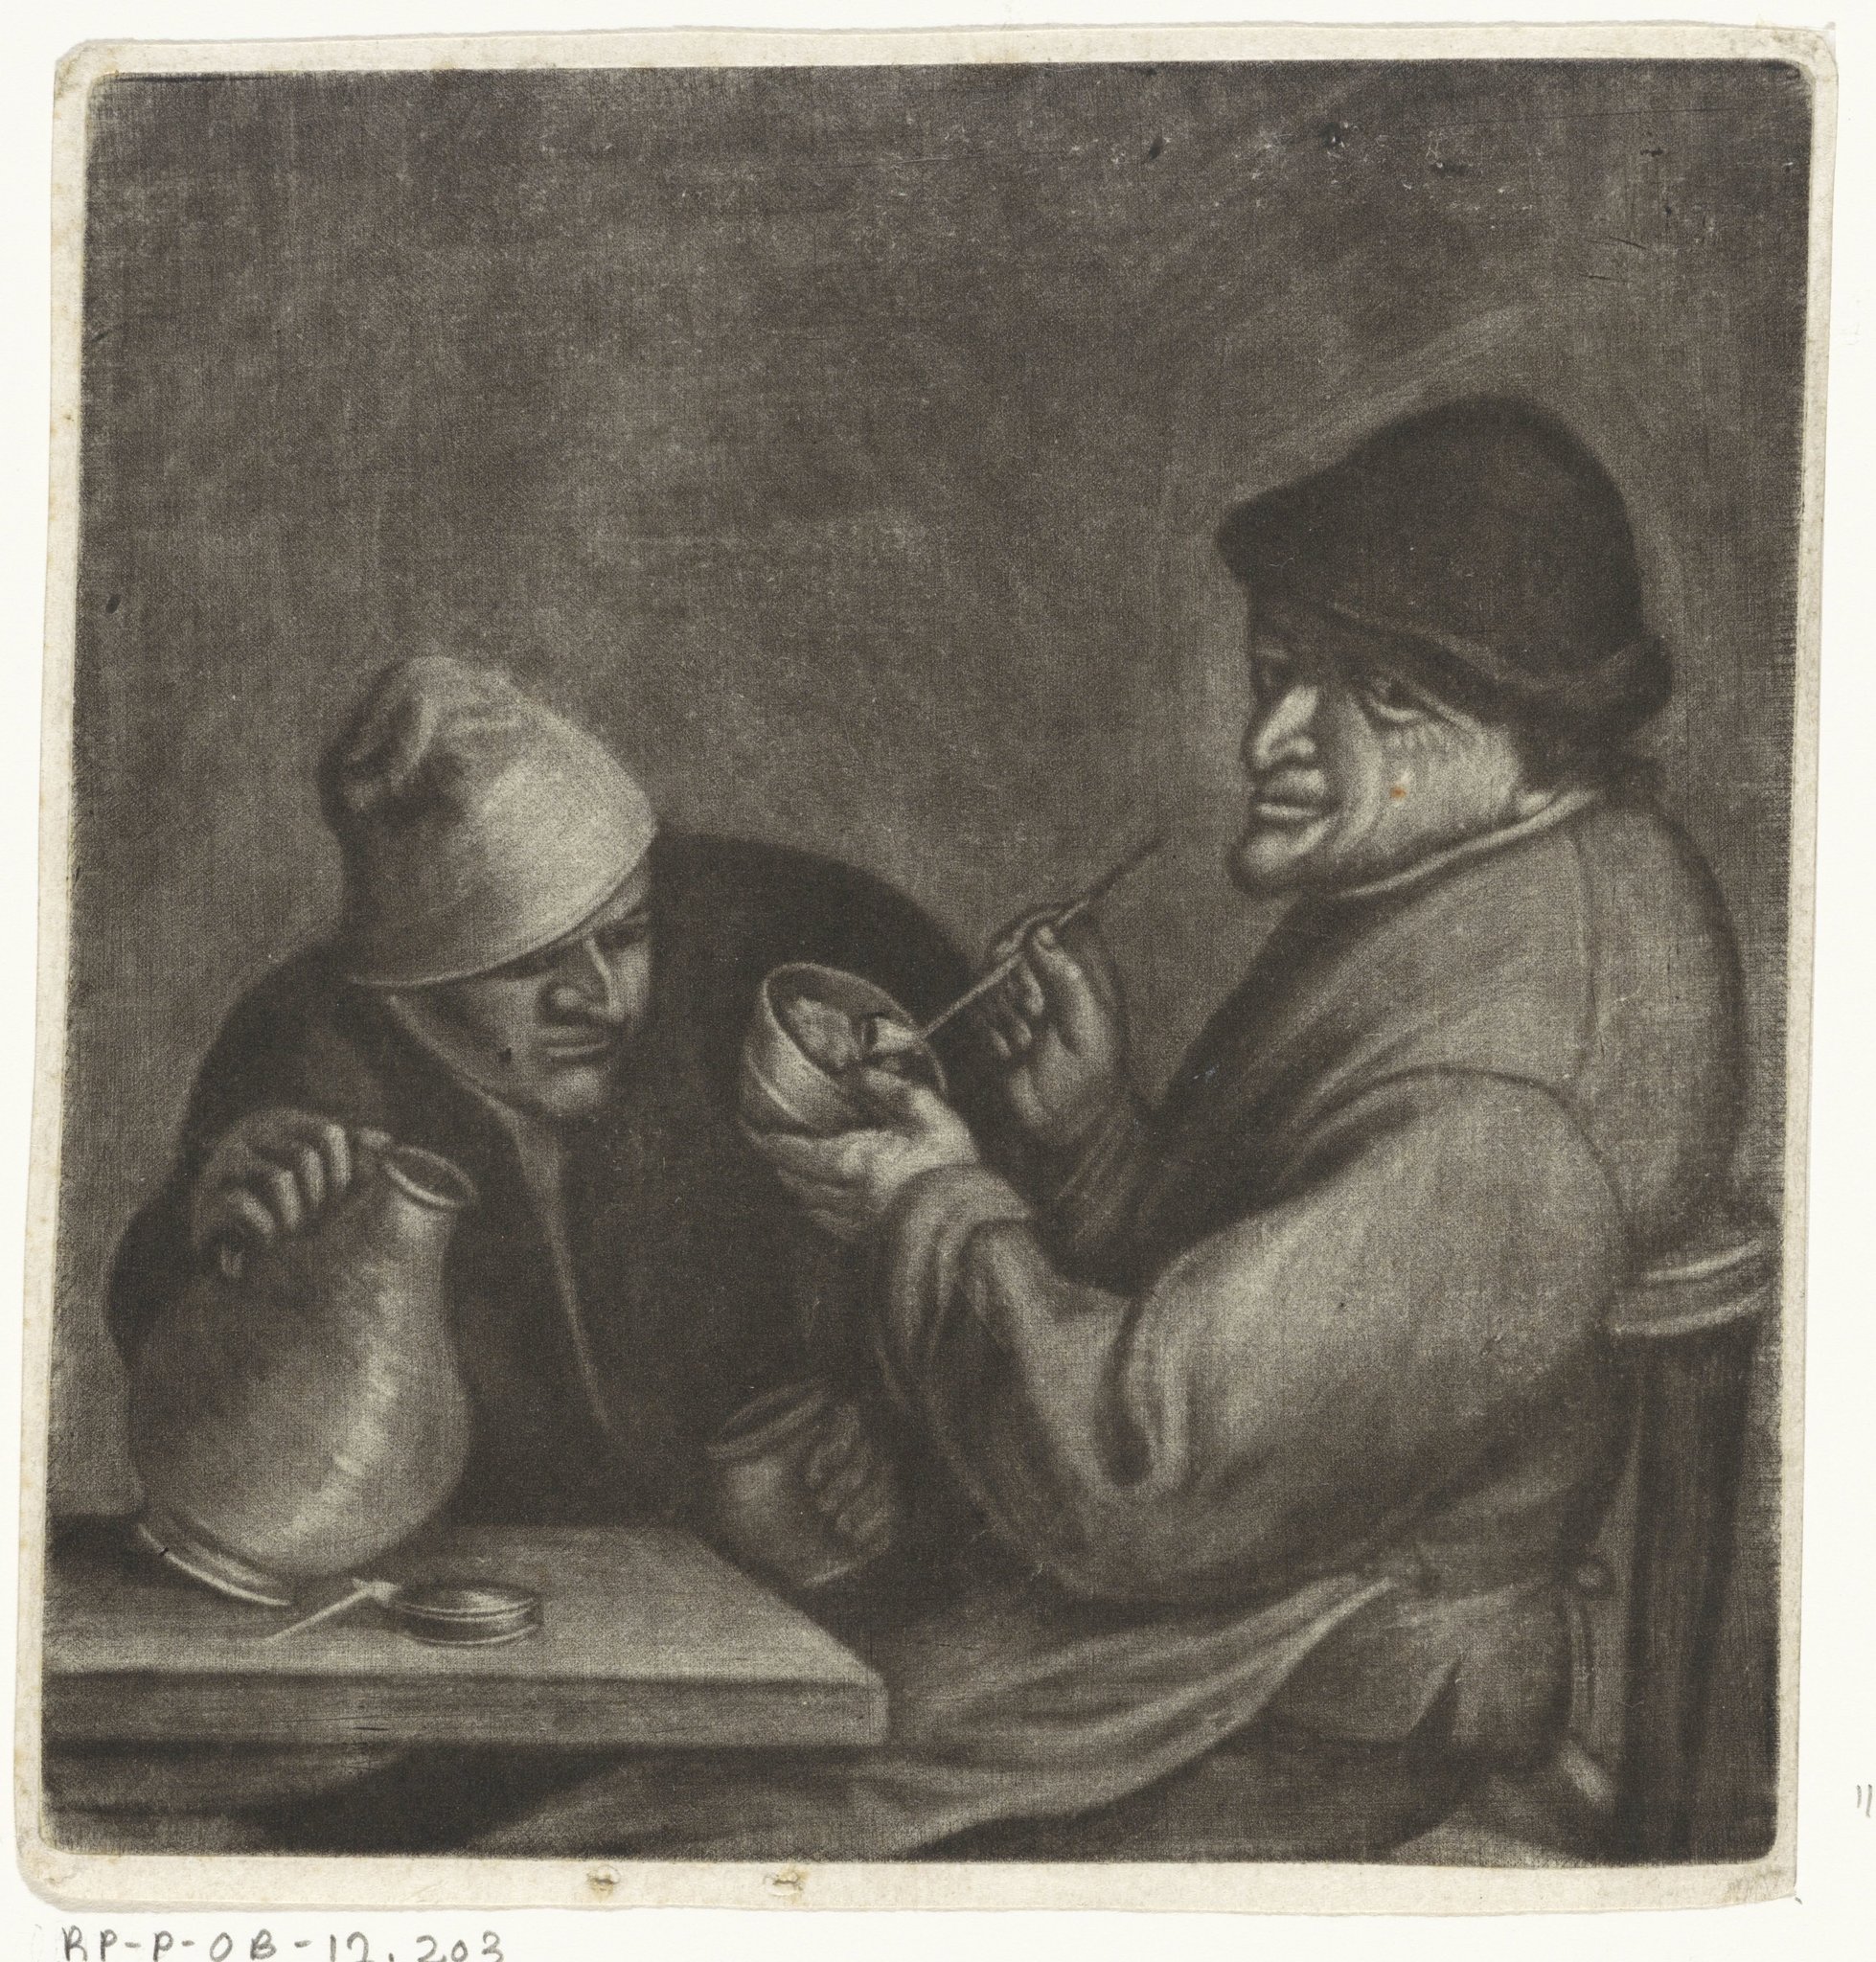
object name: print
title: Roker en drinker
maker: jacob hoolaart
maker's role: print maker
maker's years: 1713-1789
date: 1723-1789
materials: paper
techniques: mezzotint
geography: dordrecht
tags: pipe ~ tobacco, drinking-vessels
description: Aan een tafel zitten twee mannen waarvan er een zijn pijp aansteekt. De ander schenkt zijn glas vol. Ze dragen beiden een muts.